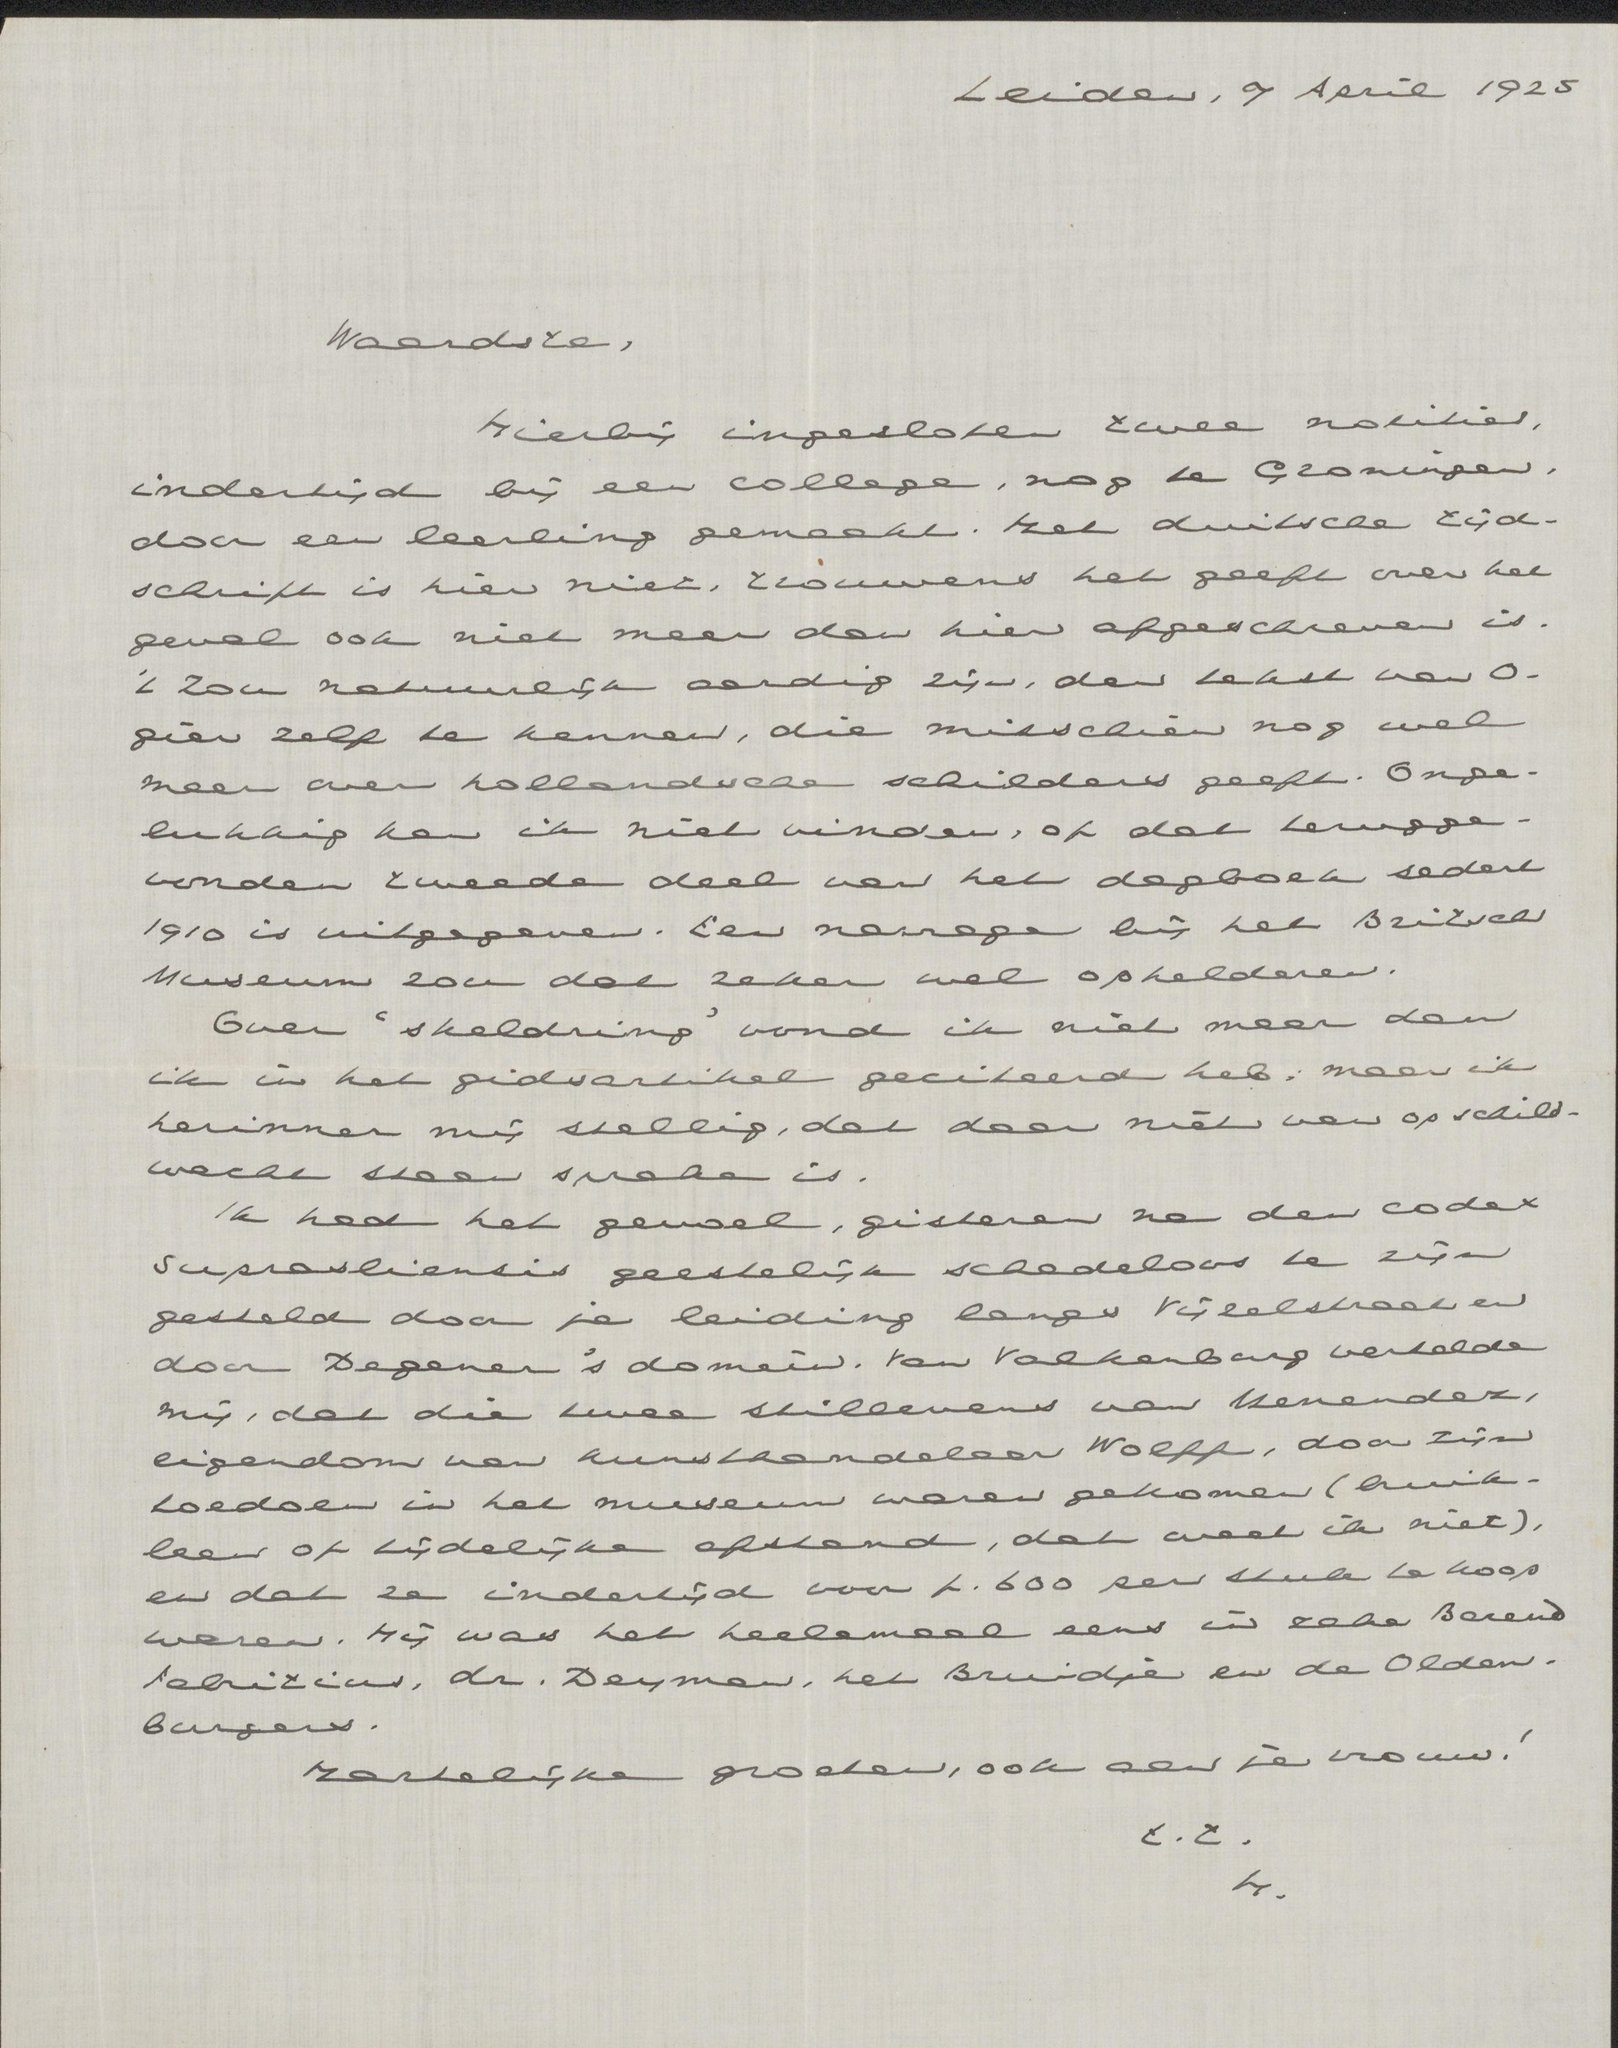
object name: letter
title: Brief aan Jan Veth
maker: johan huizinga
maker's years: 1872-1945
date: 1925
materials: ink, paper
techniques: pen, writing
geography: leiden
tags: painter, draughtsman, designer, jan veth, rotterdam, amsterdam, frederik schmidt-degener, art trade, art shop, money, printed matter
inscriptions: watermark, collector's mark: ‘RPK’